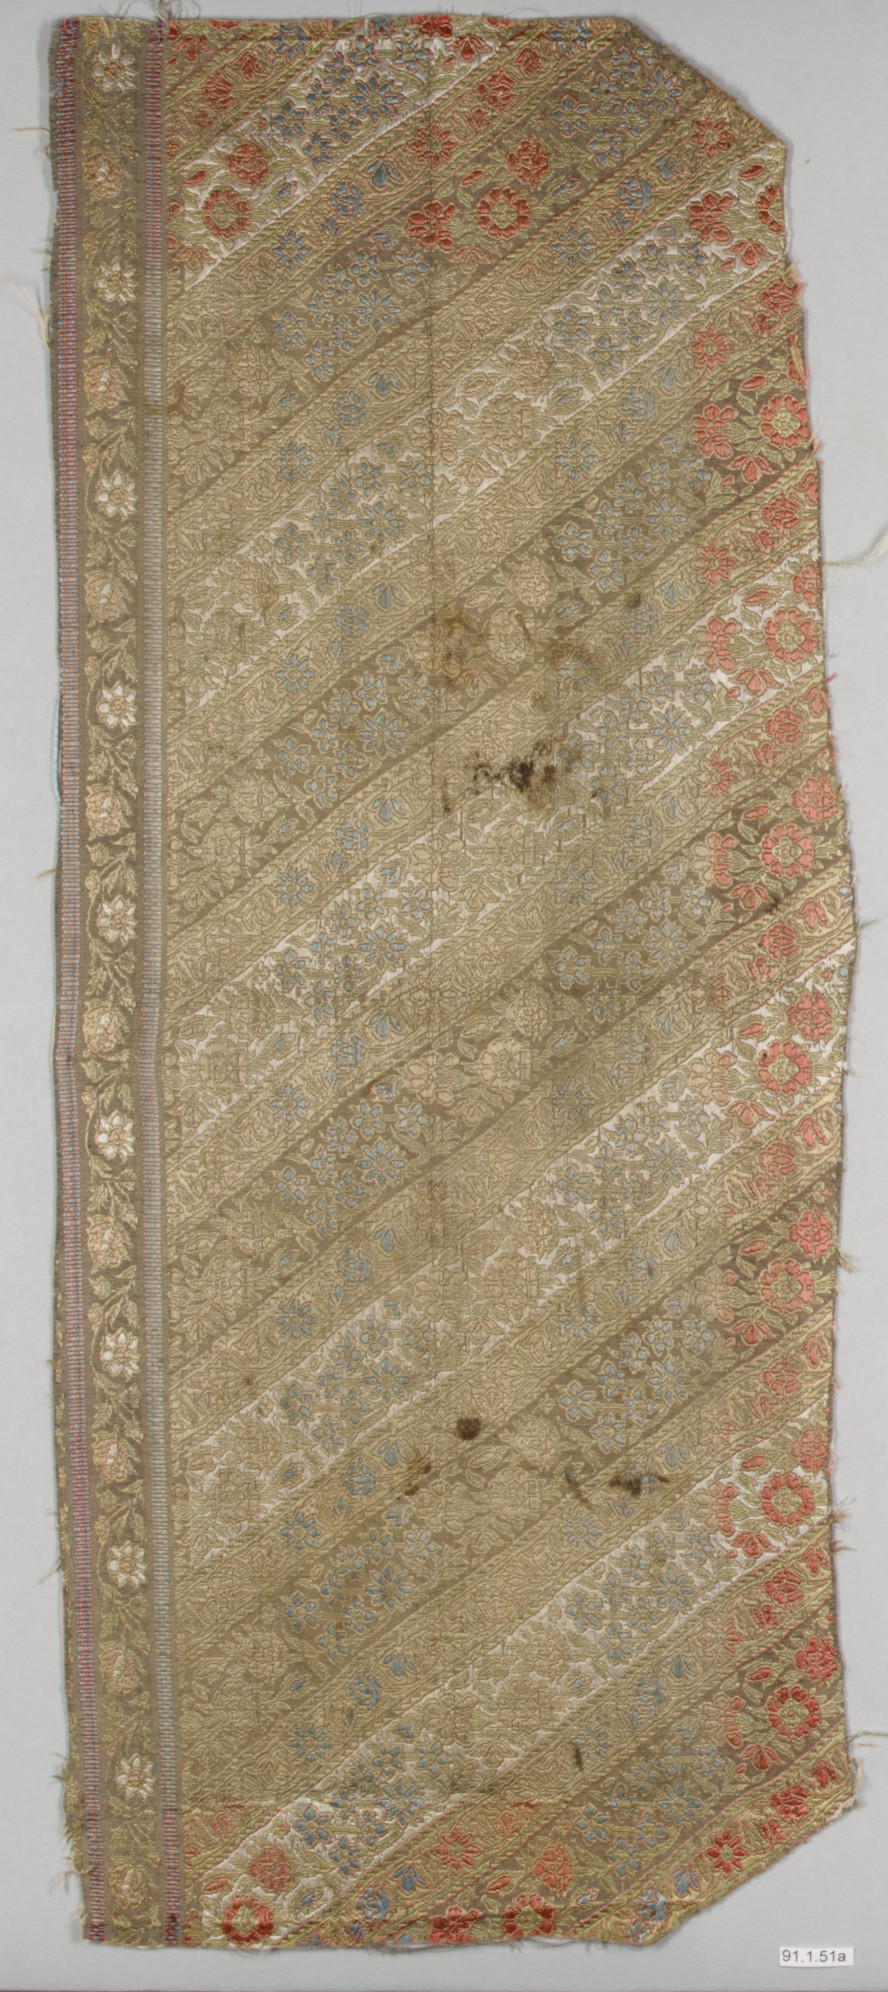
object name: trousering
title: Fragment of Woman's Trousering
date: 1801-1900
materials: silk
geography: iran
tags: flowers